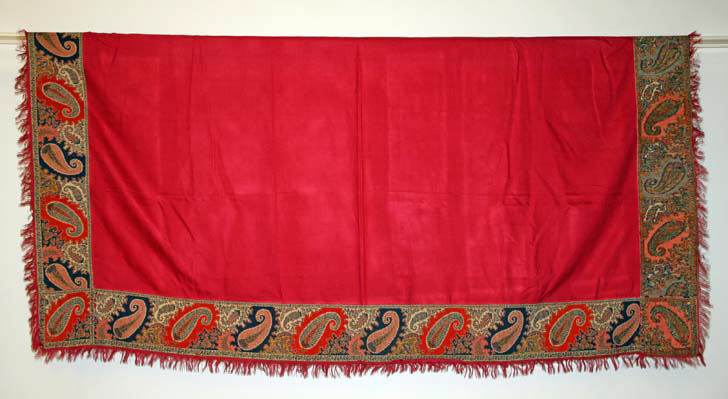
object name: shawl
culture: european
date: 1834-1866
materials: silk